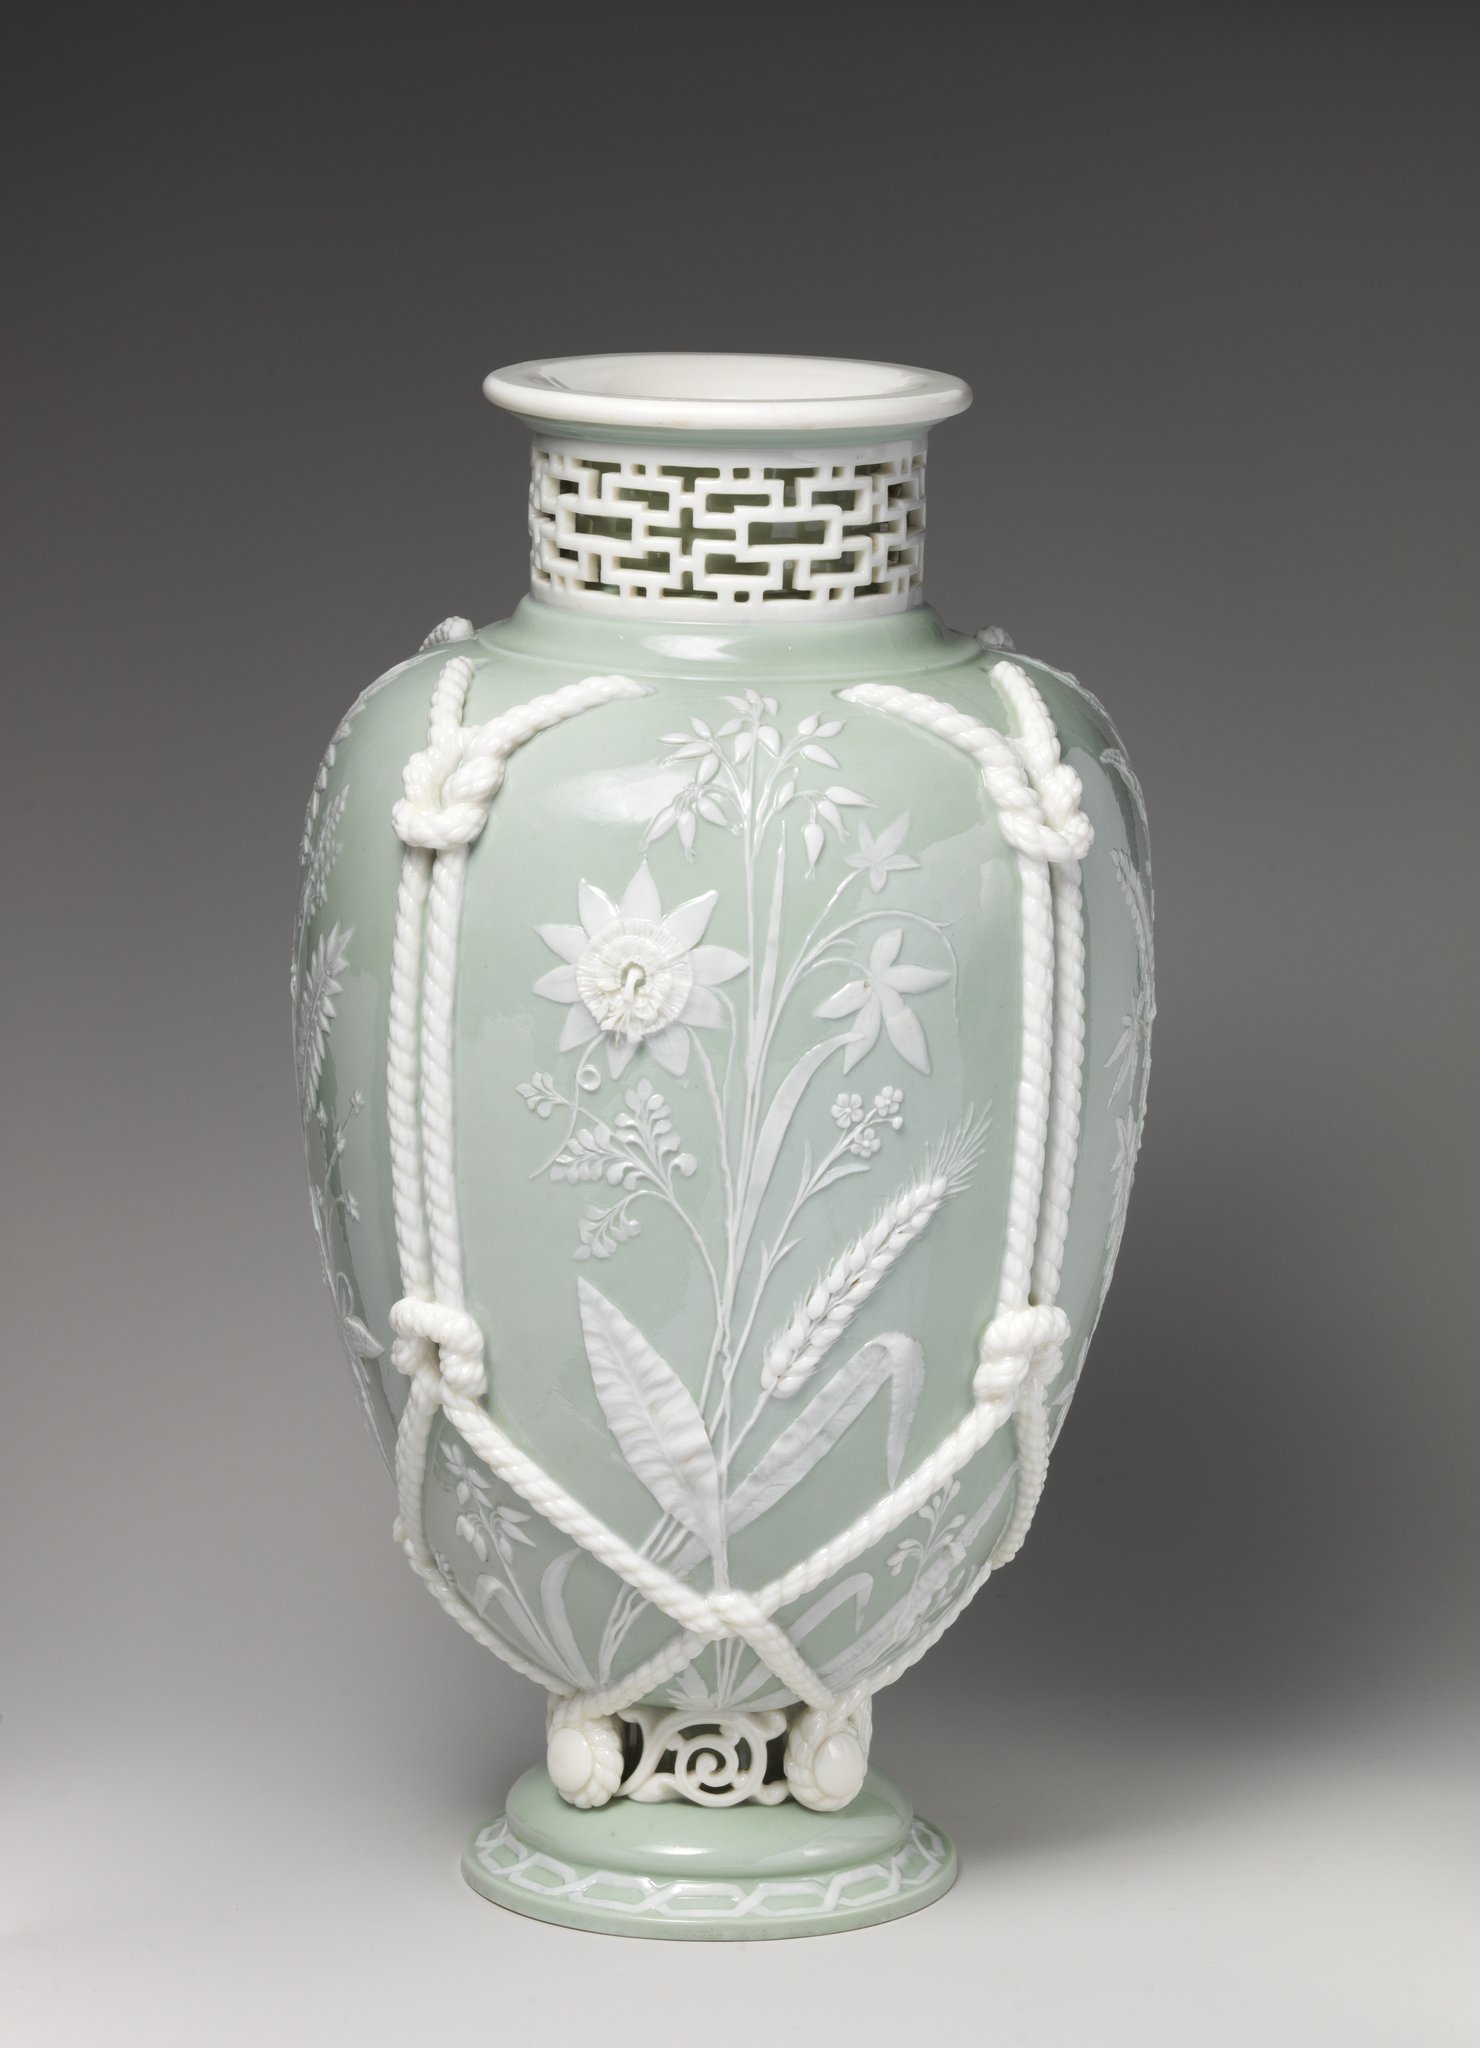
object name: vase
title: Vase with rope and wheat decoration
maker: minton(s)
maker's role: maker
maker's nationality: british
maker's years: 1793-2001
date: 1864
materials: bone china